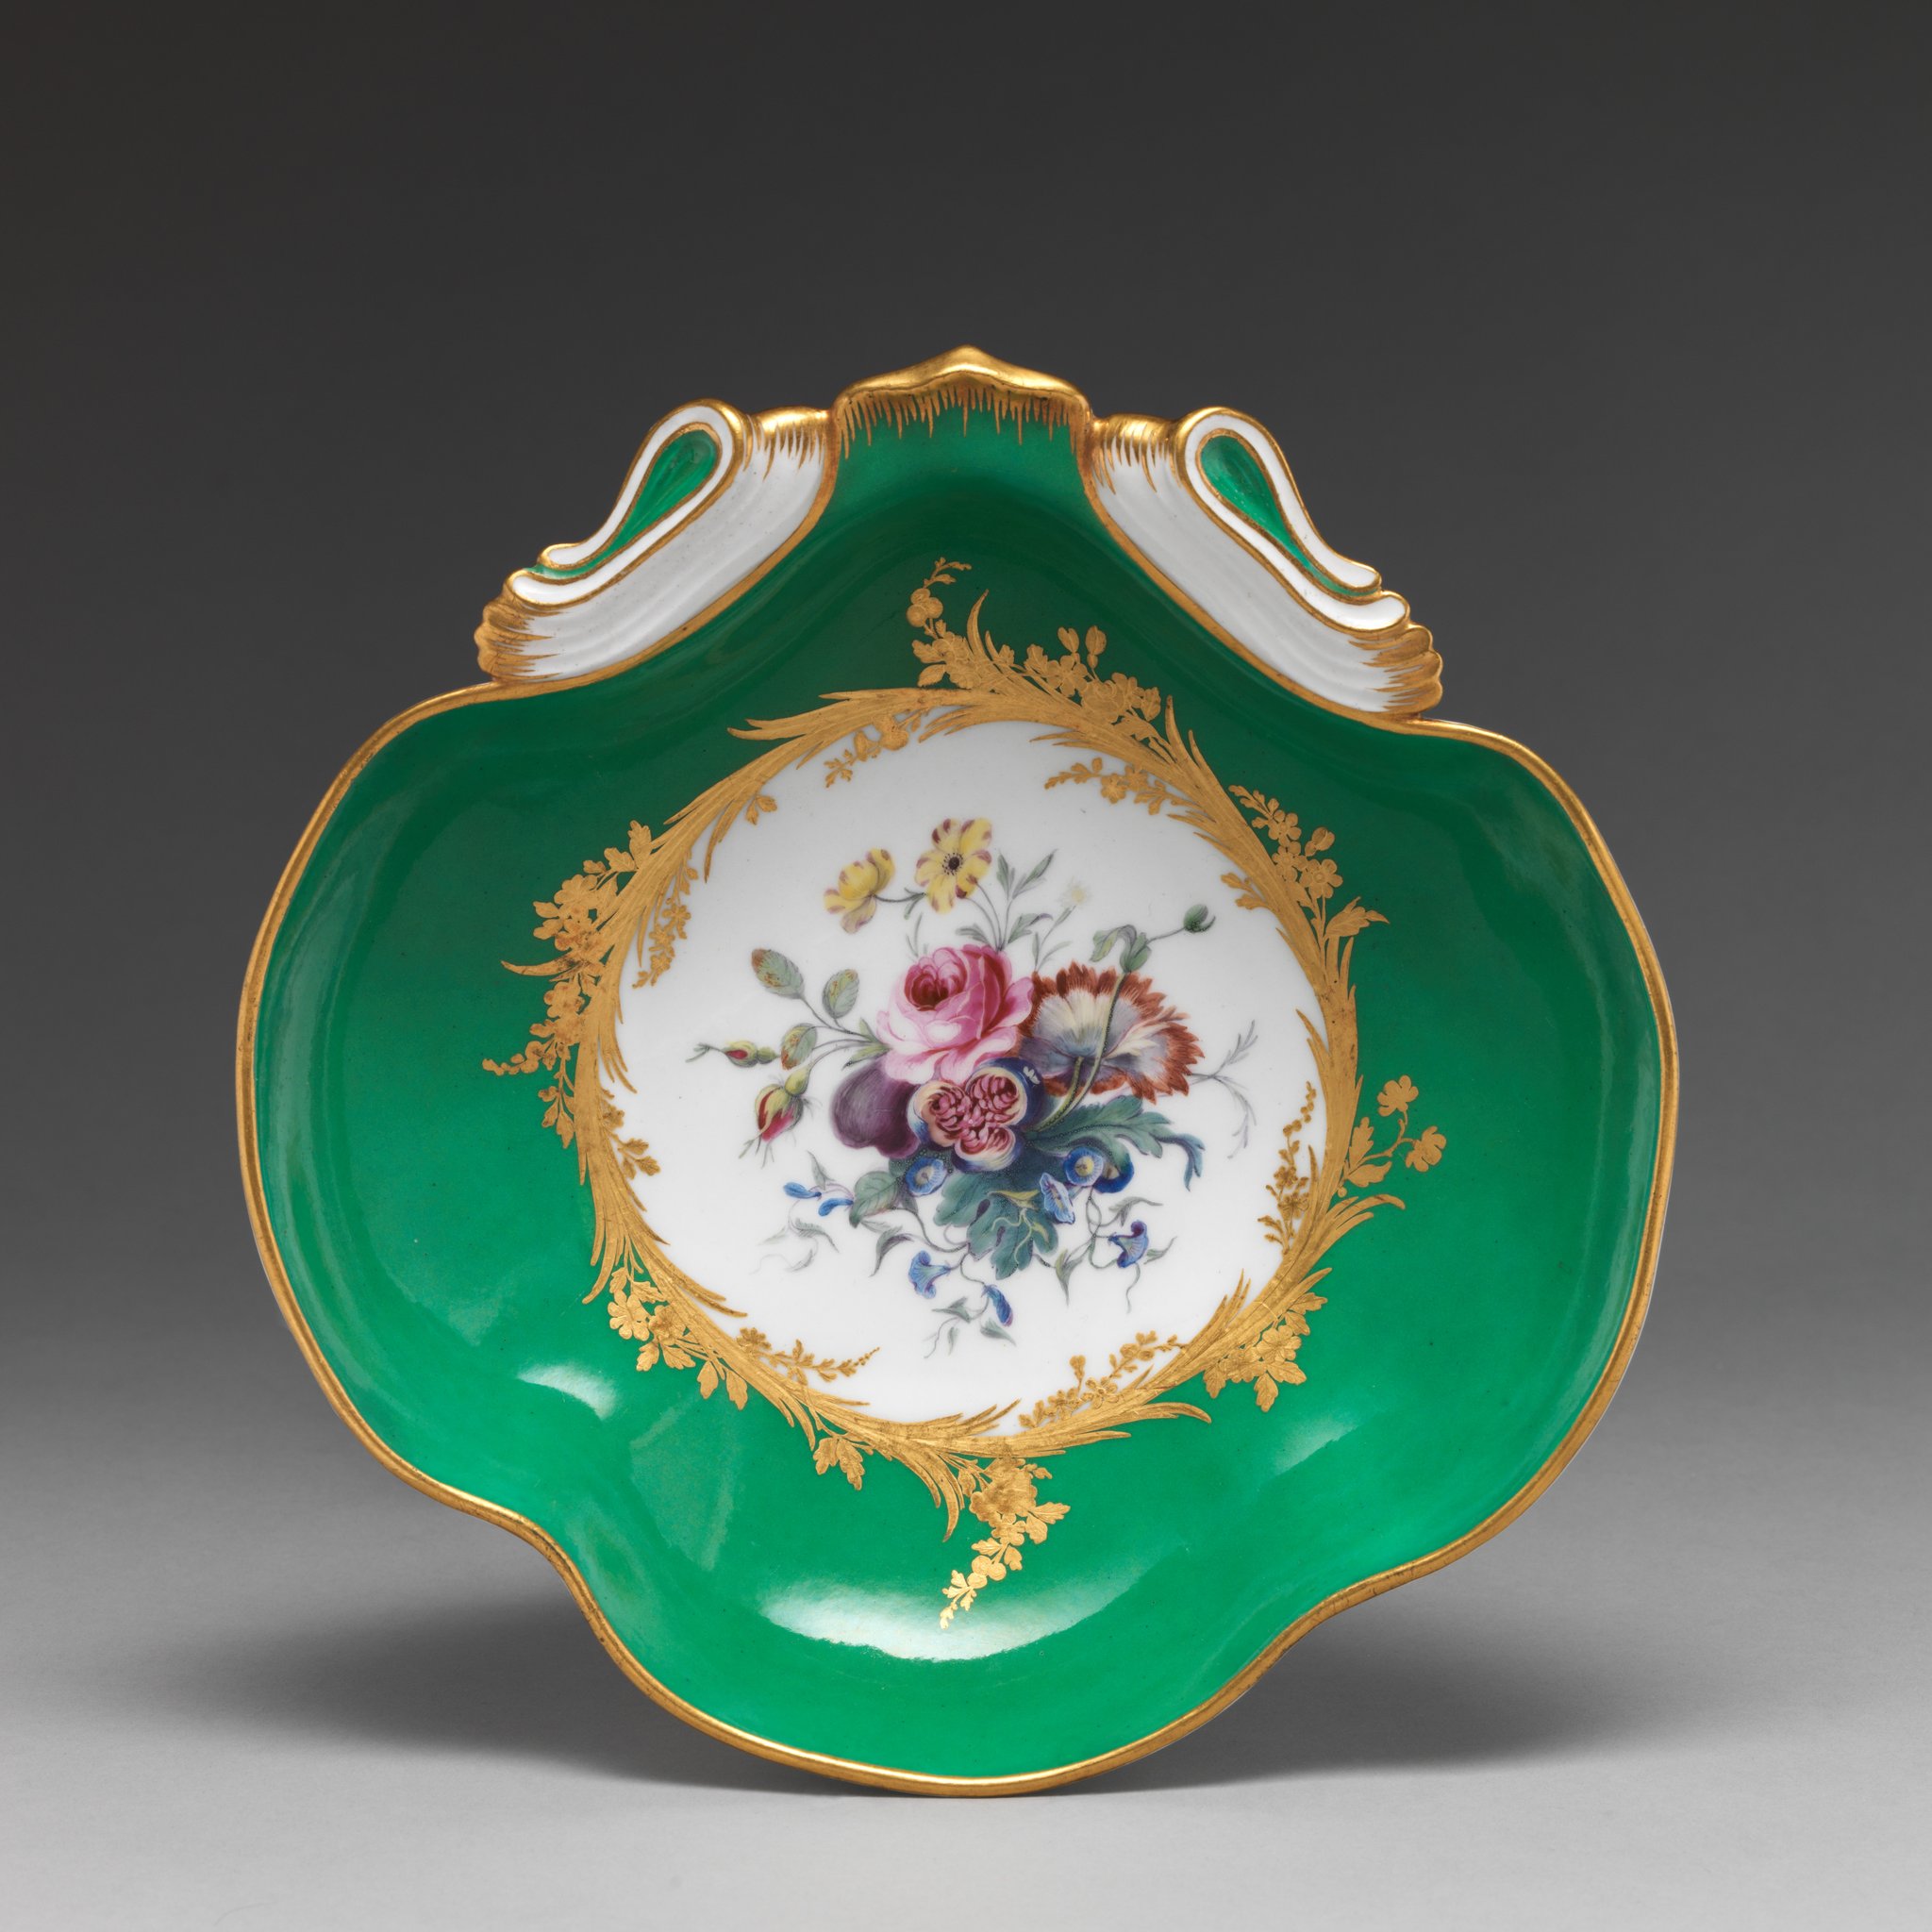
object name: fruit dish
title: Fruit dish (compotier coquille) (one of four) (part of a service)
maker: sèvres manufactory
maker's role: manufactory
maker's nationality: french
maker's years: 1740-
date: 1780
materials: soft paste porcelain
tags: flowers